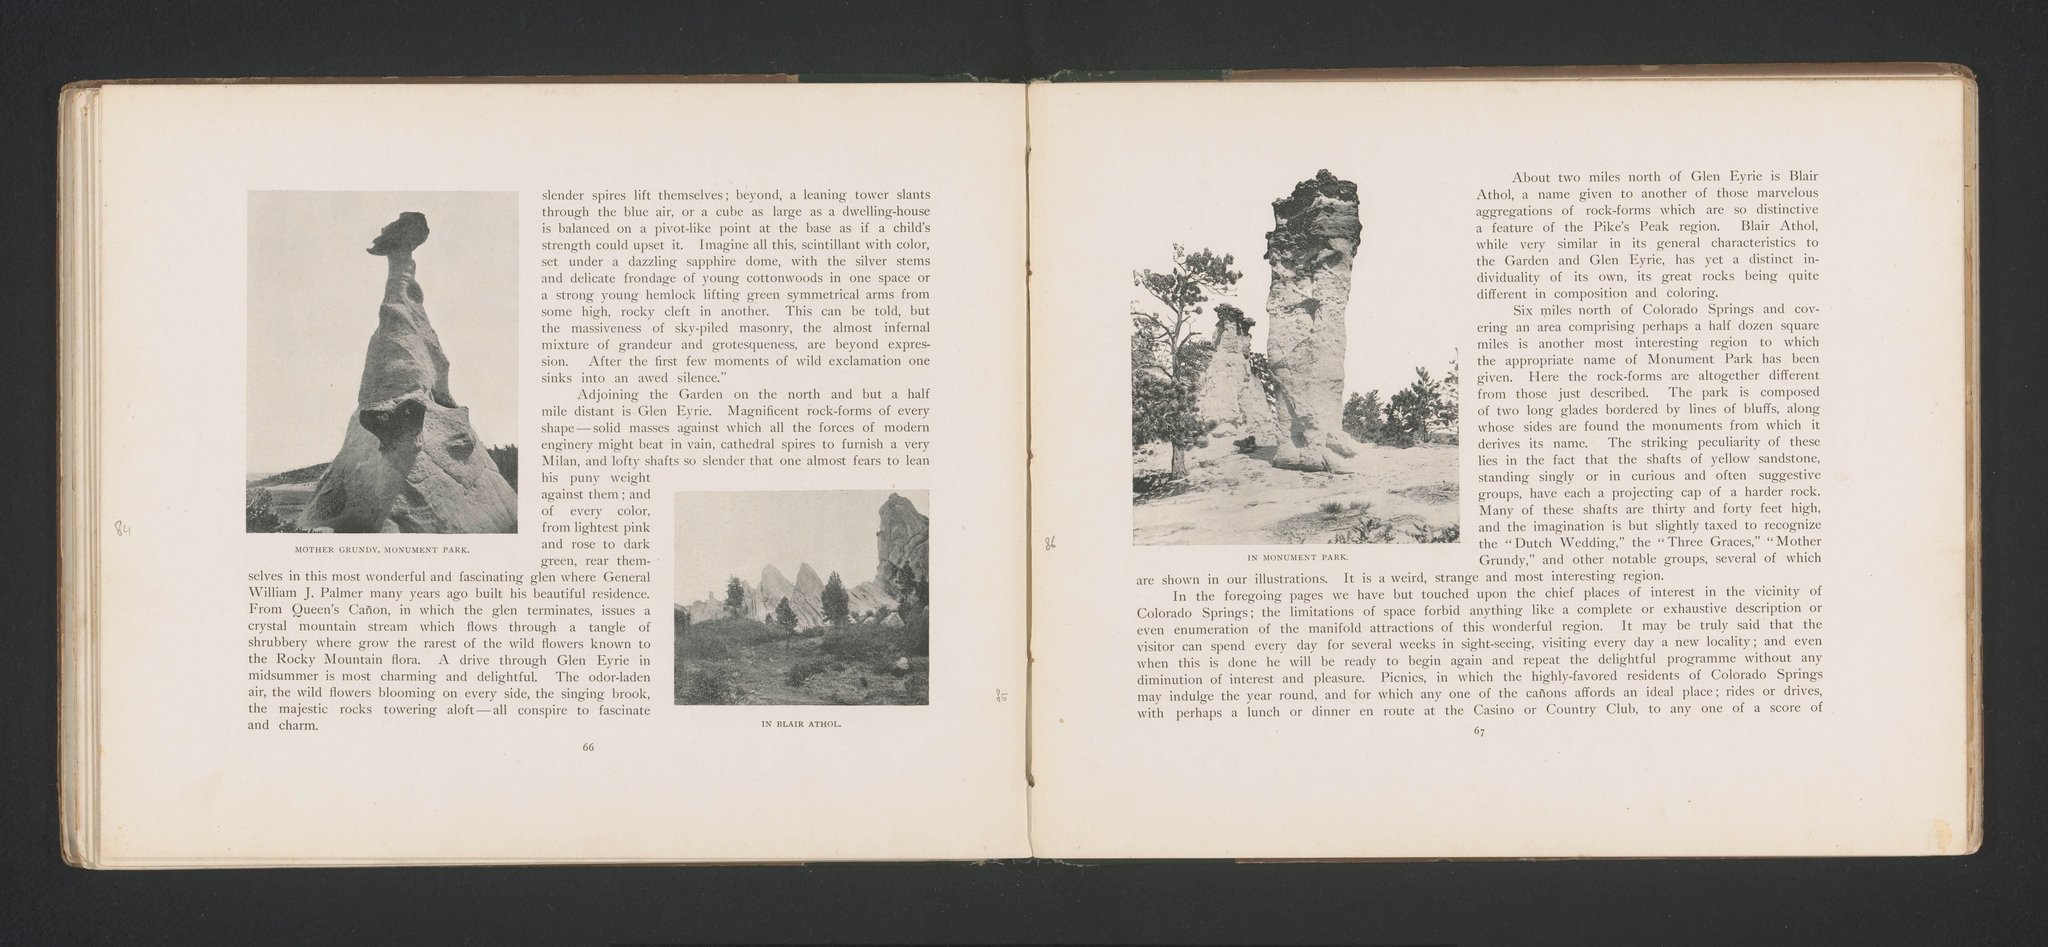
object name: photomechanical print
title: Mother Grundy, Monument Park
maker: Anonymous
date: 1888-1893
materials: paper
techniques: autotype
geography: new york city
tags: rock-formations